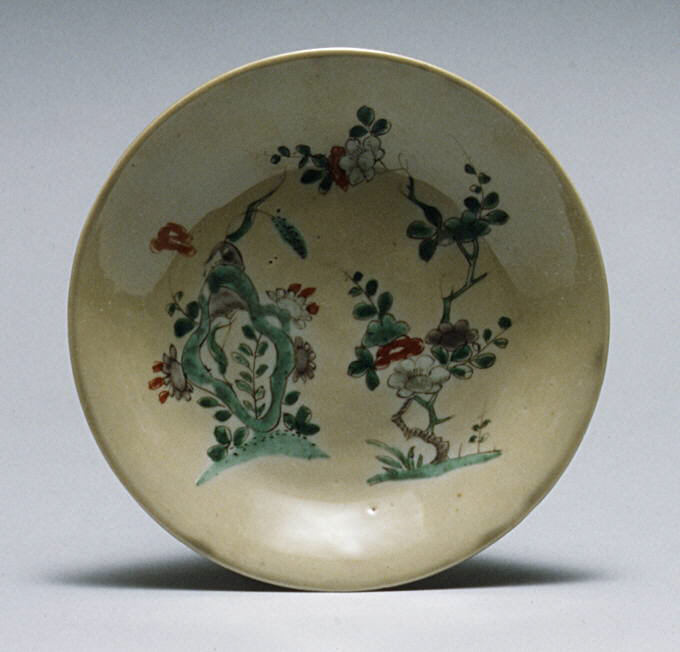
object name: saucer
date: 1701-1733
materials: hard paste porcelain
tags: flowers,plants